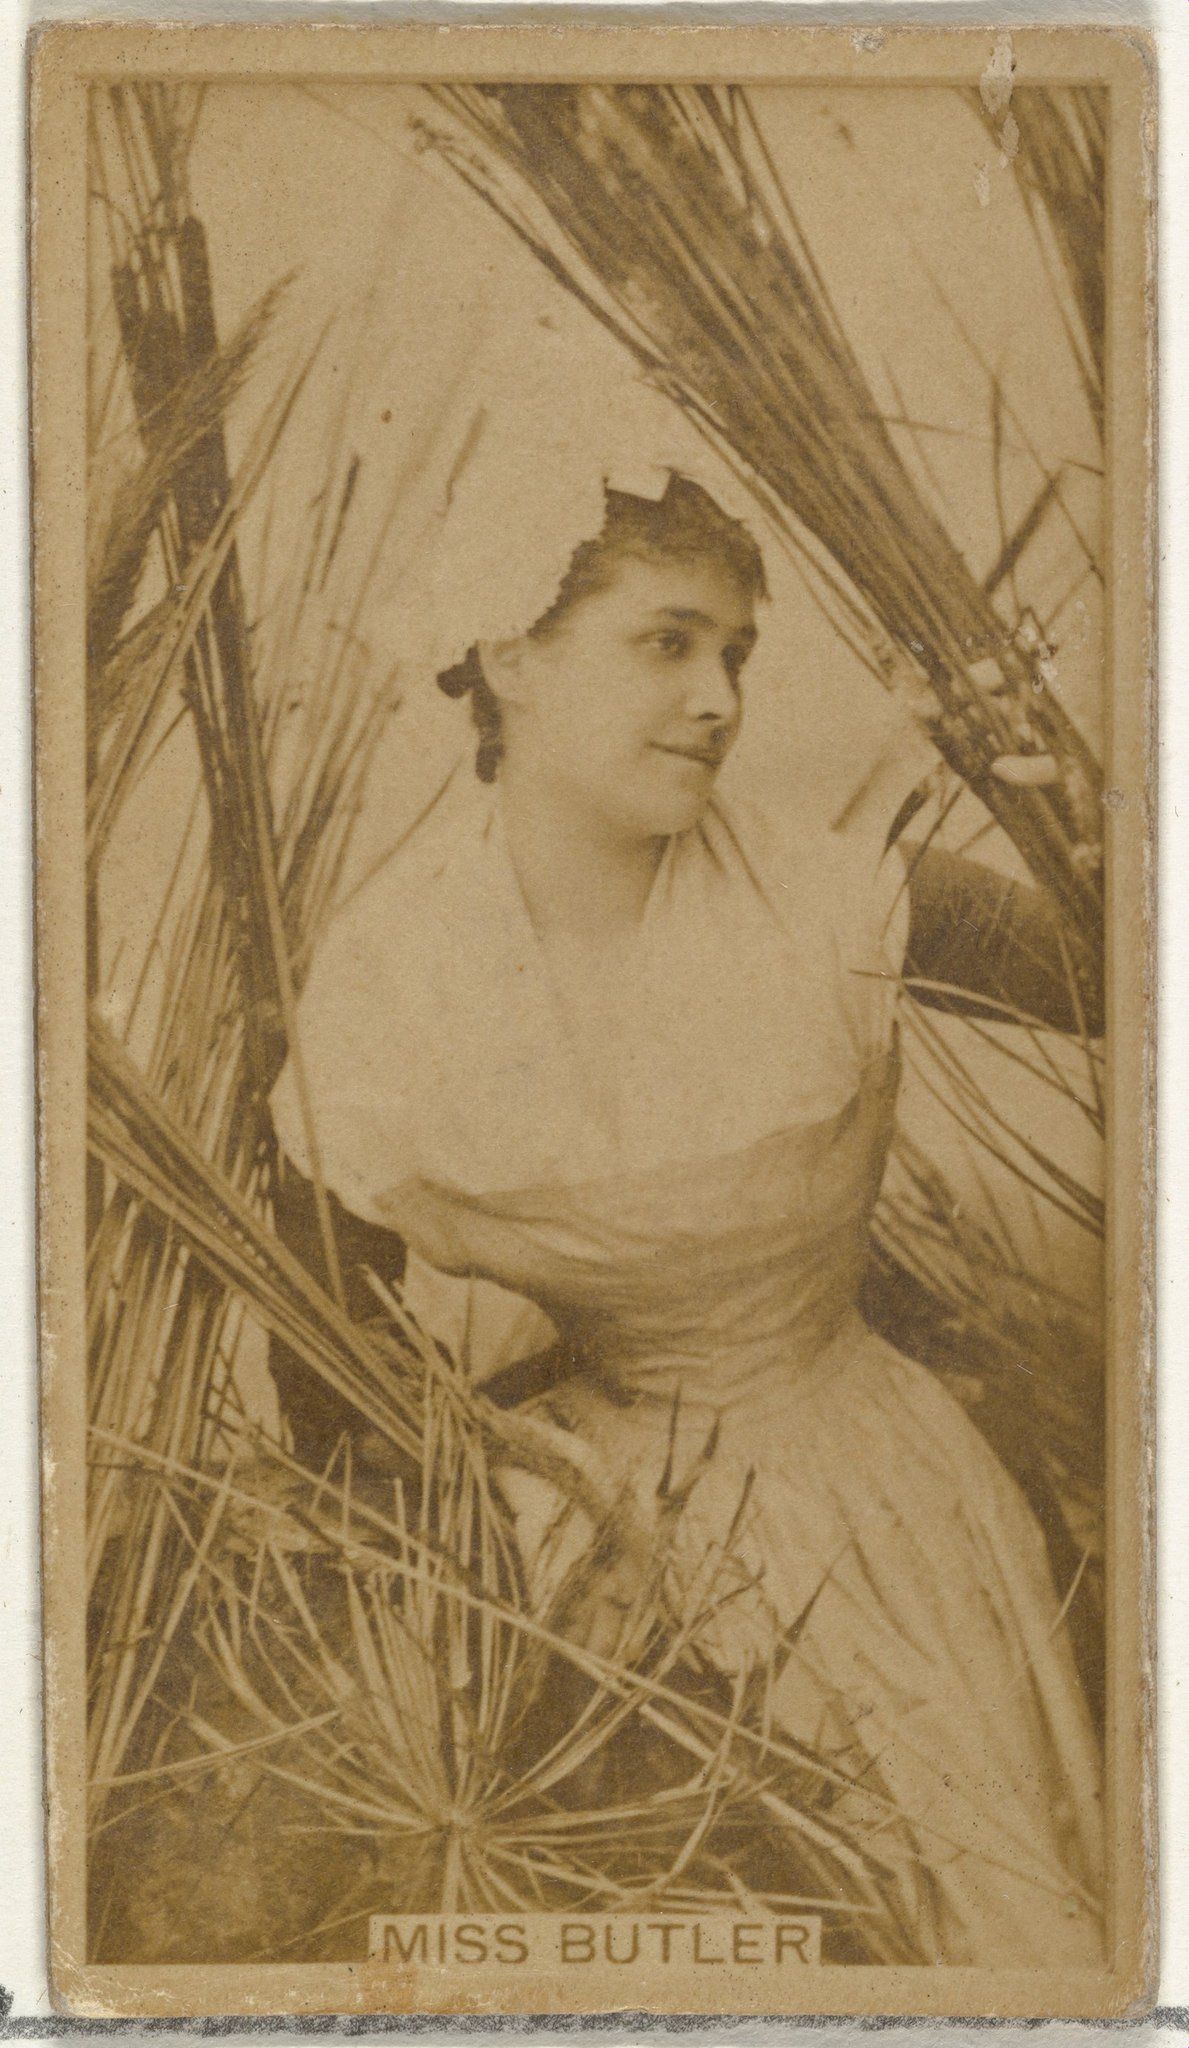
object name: photograph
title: Miss Butler, from the Actors and Actresses series (N145-8) issued by Duke Sons & Co. to promote Duke Cigarettes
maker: w. duke, sons & co.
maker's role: publisher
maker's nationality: american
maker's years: 1870-1920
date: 1891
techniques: albumen silver print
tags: portraits,women,actresses